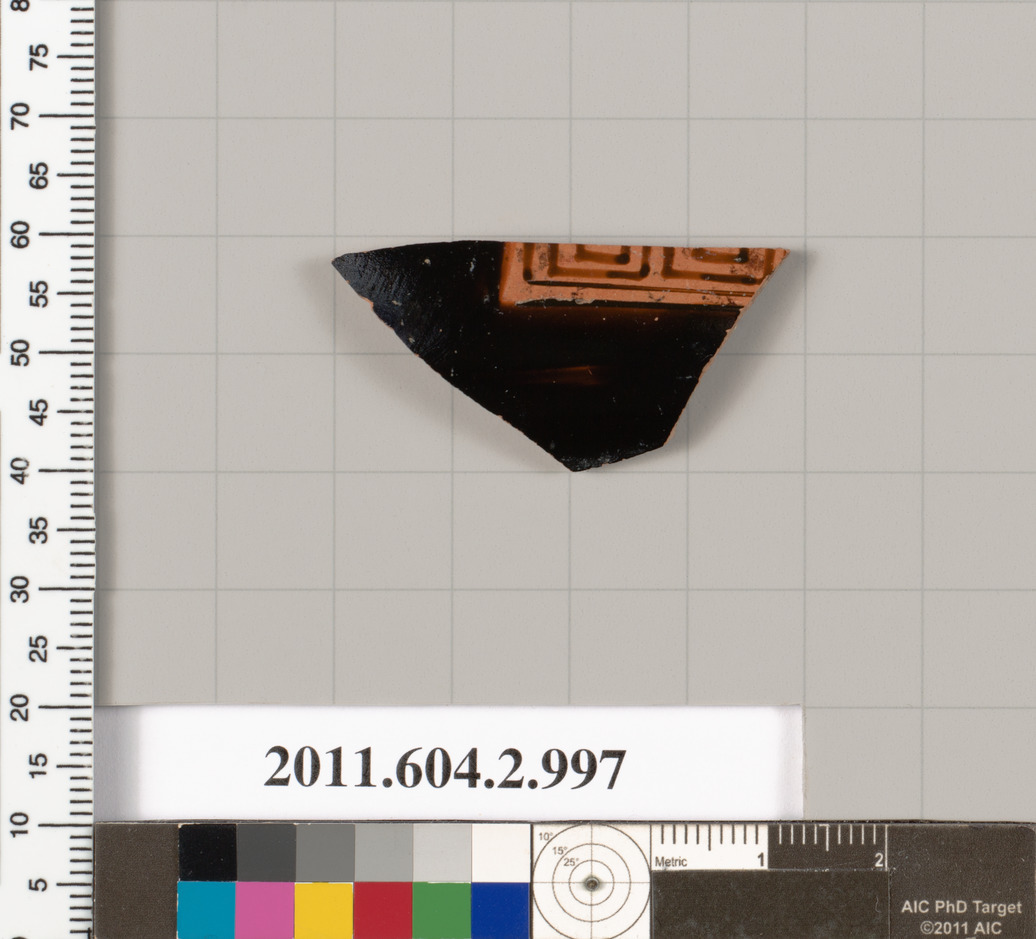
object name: oinochoe fragment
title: Terracotta fragment of an oinochoe (jug)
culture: greek, attic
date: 460-440 BCE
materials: terracotta